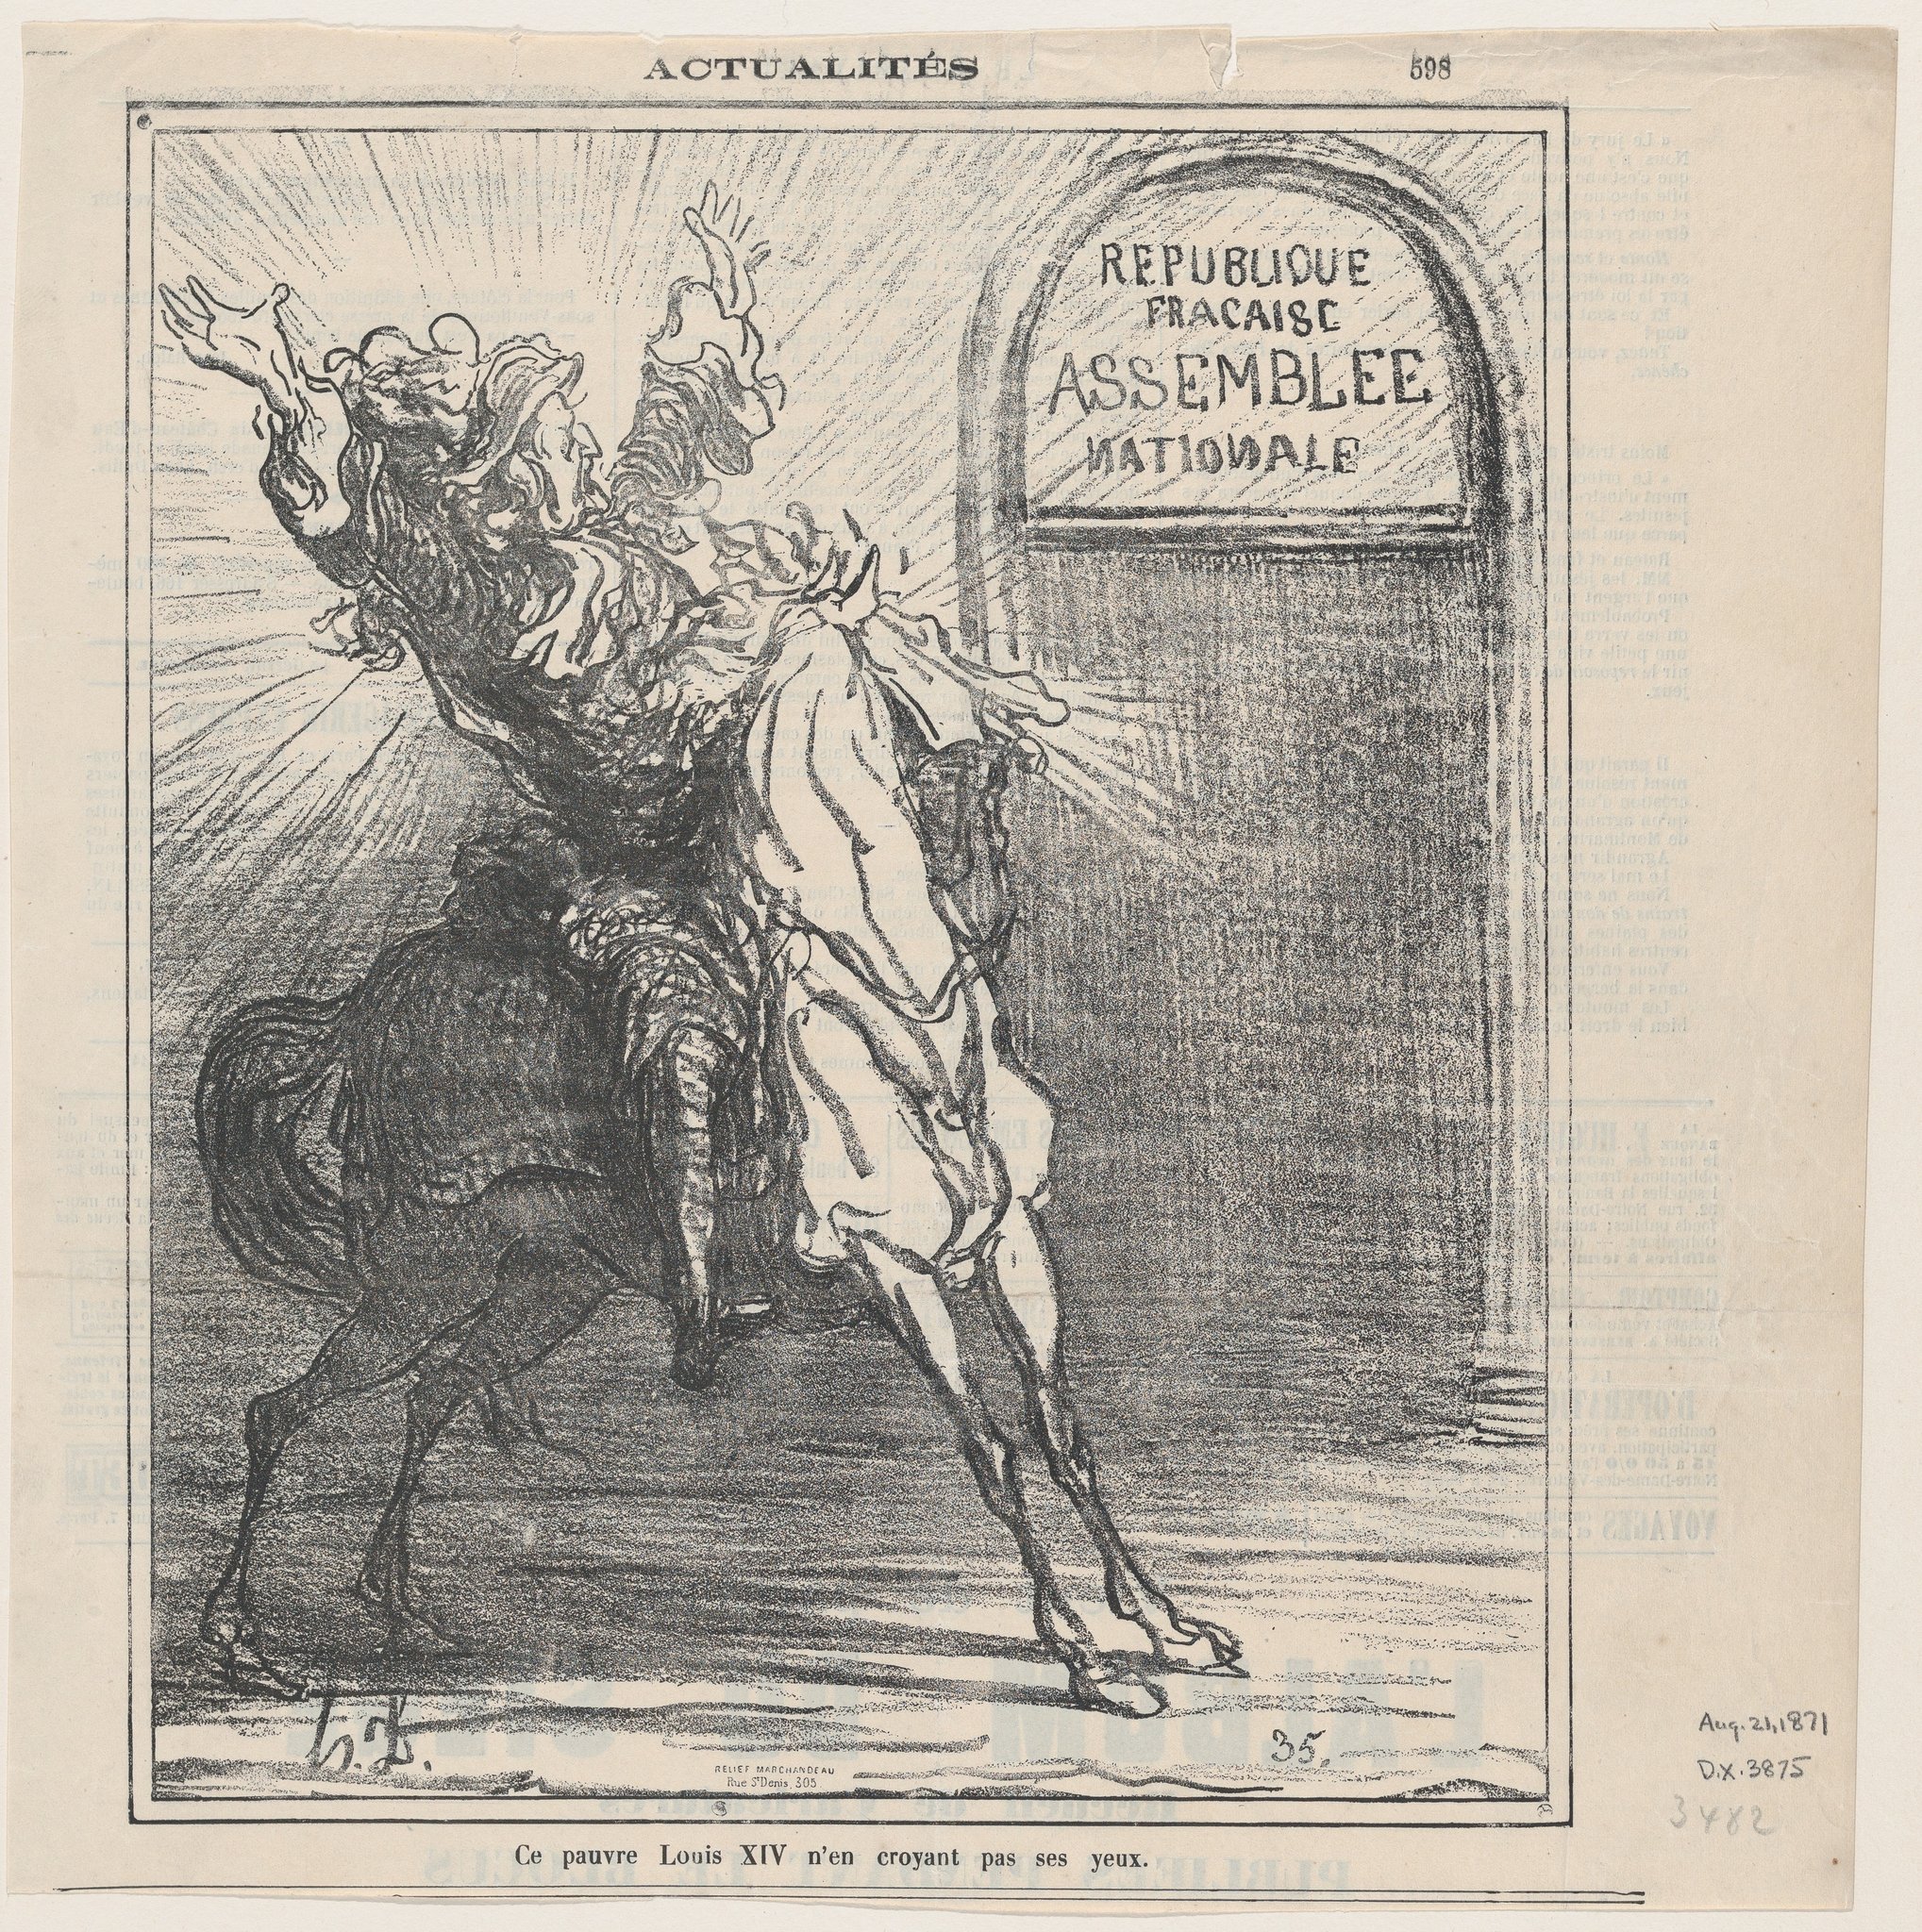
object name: print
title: This poor King Louis XIV doesn't believe his eyes, from 'News of the day,' published in Le Charivari, August 21, 1871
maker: honoré daumier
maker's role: artist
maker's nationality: french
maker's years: 1808-1879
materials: paper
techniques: lithograph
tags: satire,louis xiv,horses